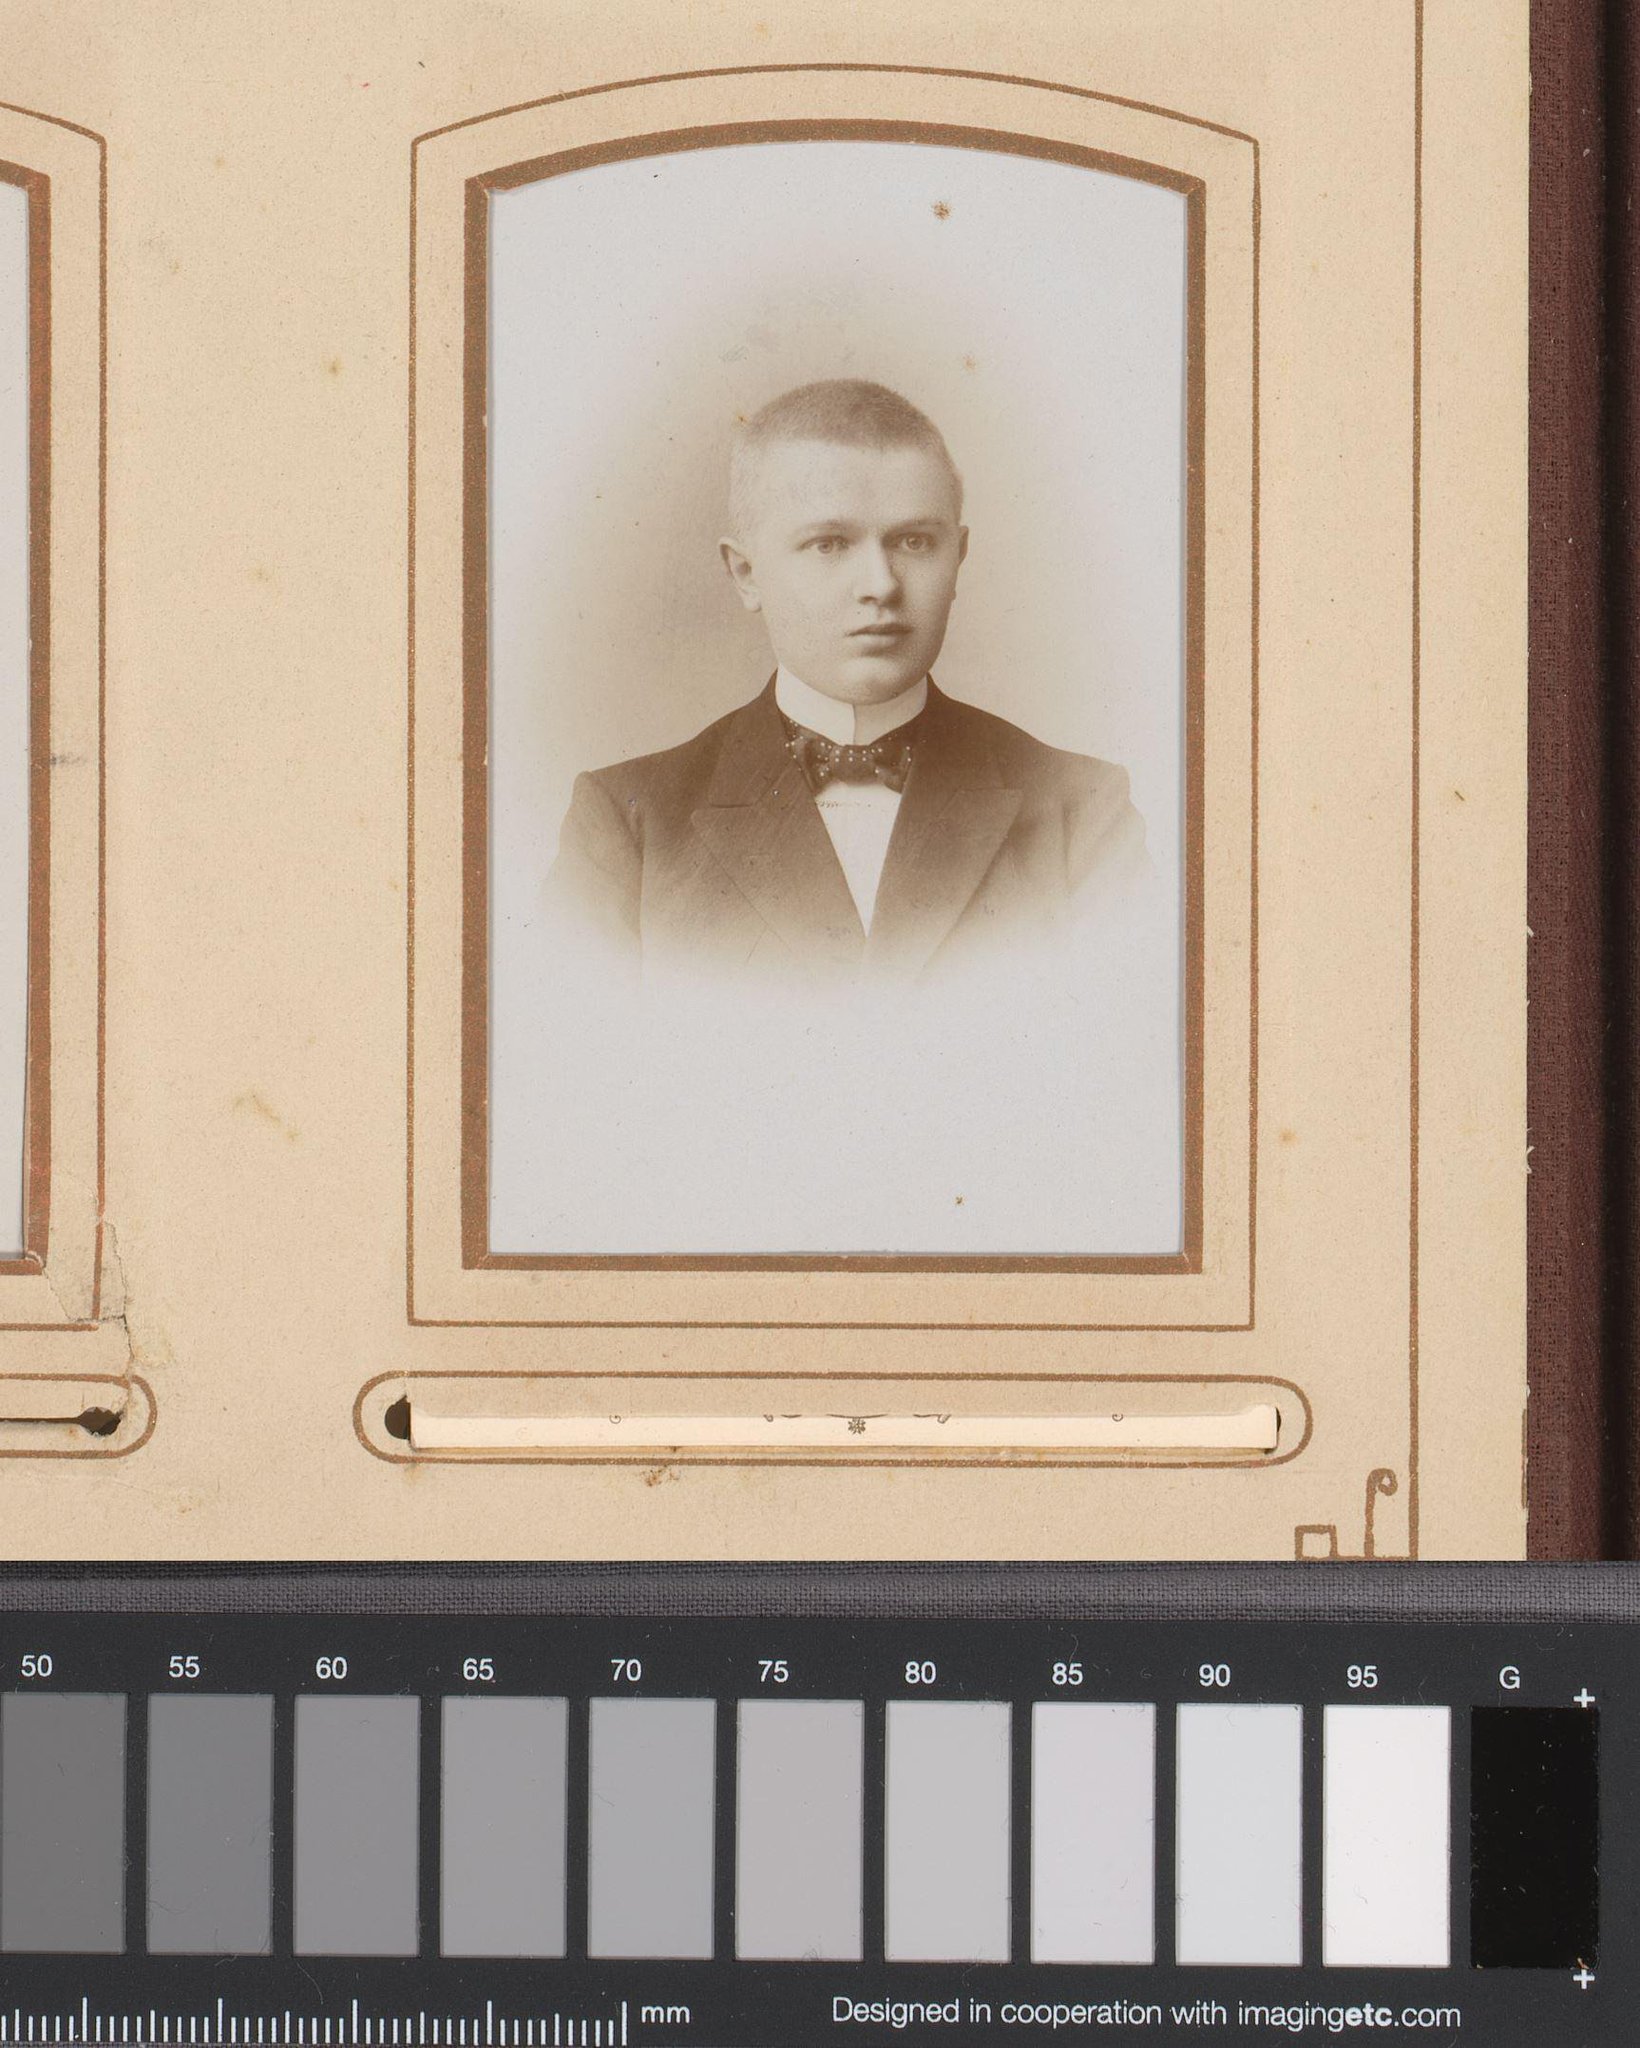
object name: album leaf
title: Portret van een jongeman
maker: alexander matthaey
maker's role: fotograaf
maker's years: 1846-1917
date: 1880-1910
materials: cardboard, photographic support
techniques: collodion silver print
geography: stettin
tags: historical persons, youth, adolescent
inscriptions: inscription: ‘Alex. Matthaey/ Stettin/ Breitestrasse 25’